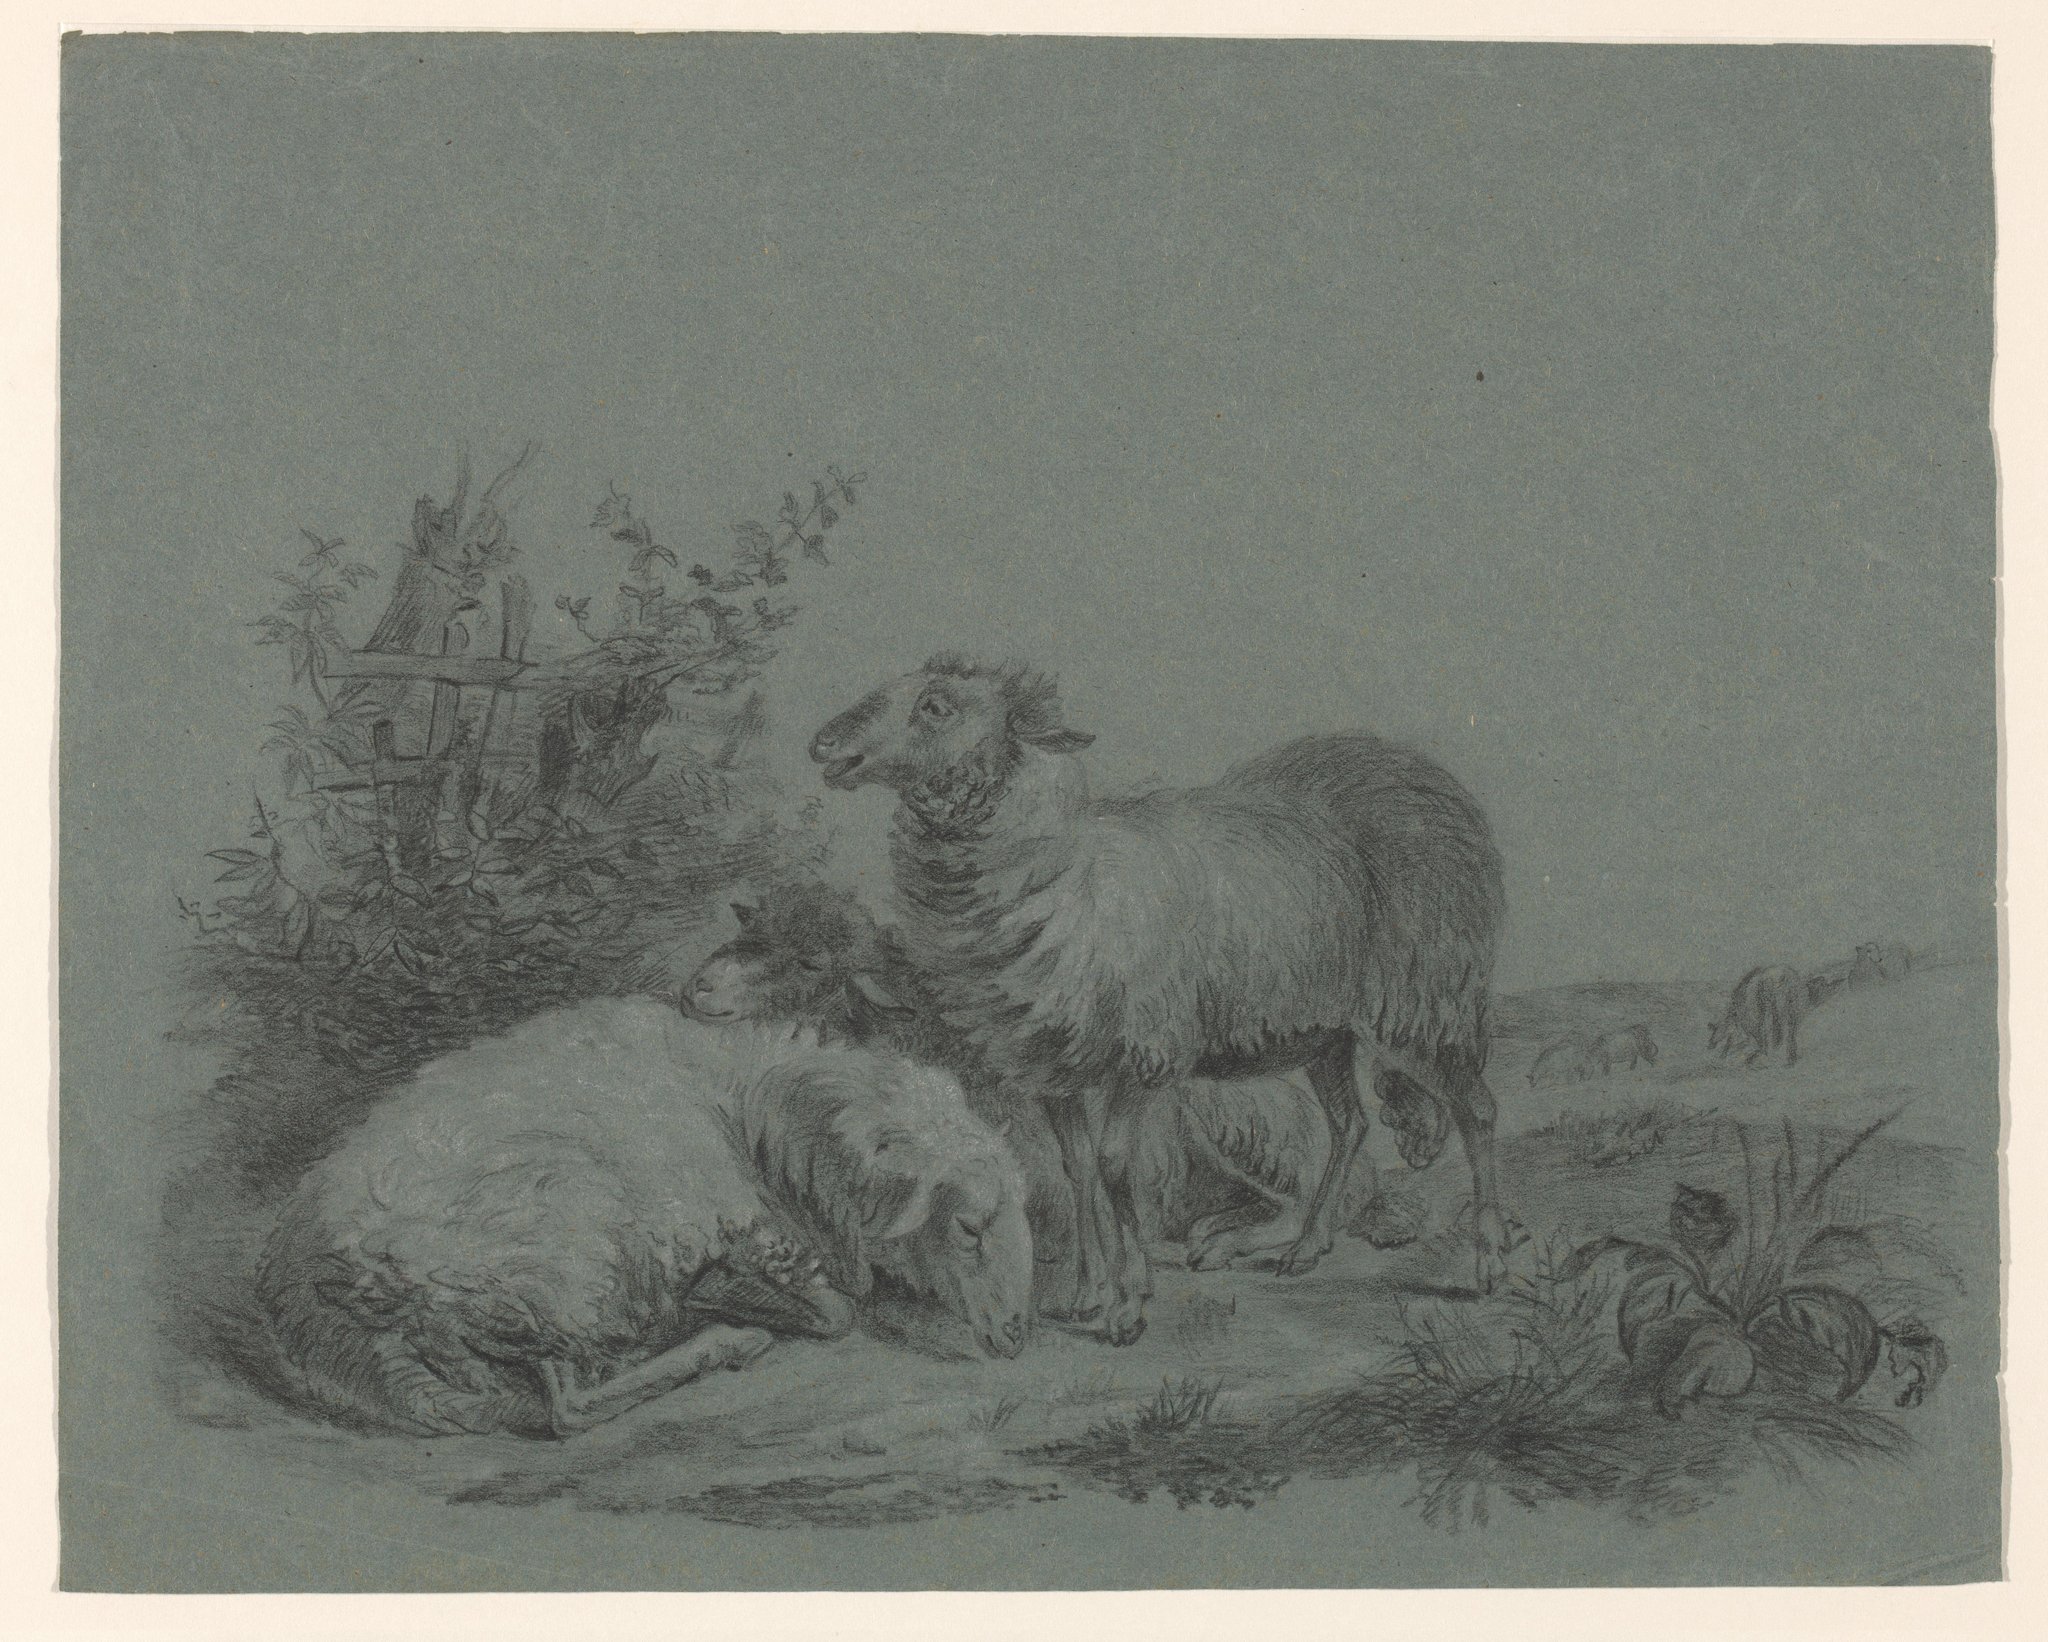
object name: drawing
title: Schapen in een weide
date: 1800-1899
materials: chalk, paper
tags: sheep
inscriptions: collector's mark: Lugt 2228a